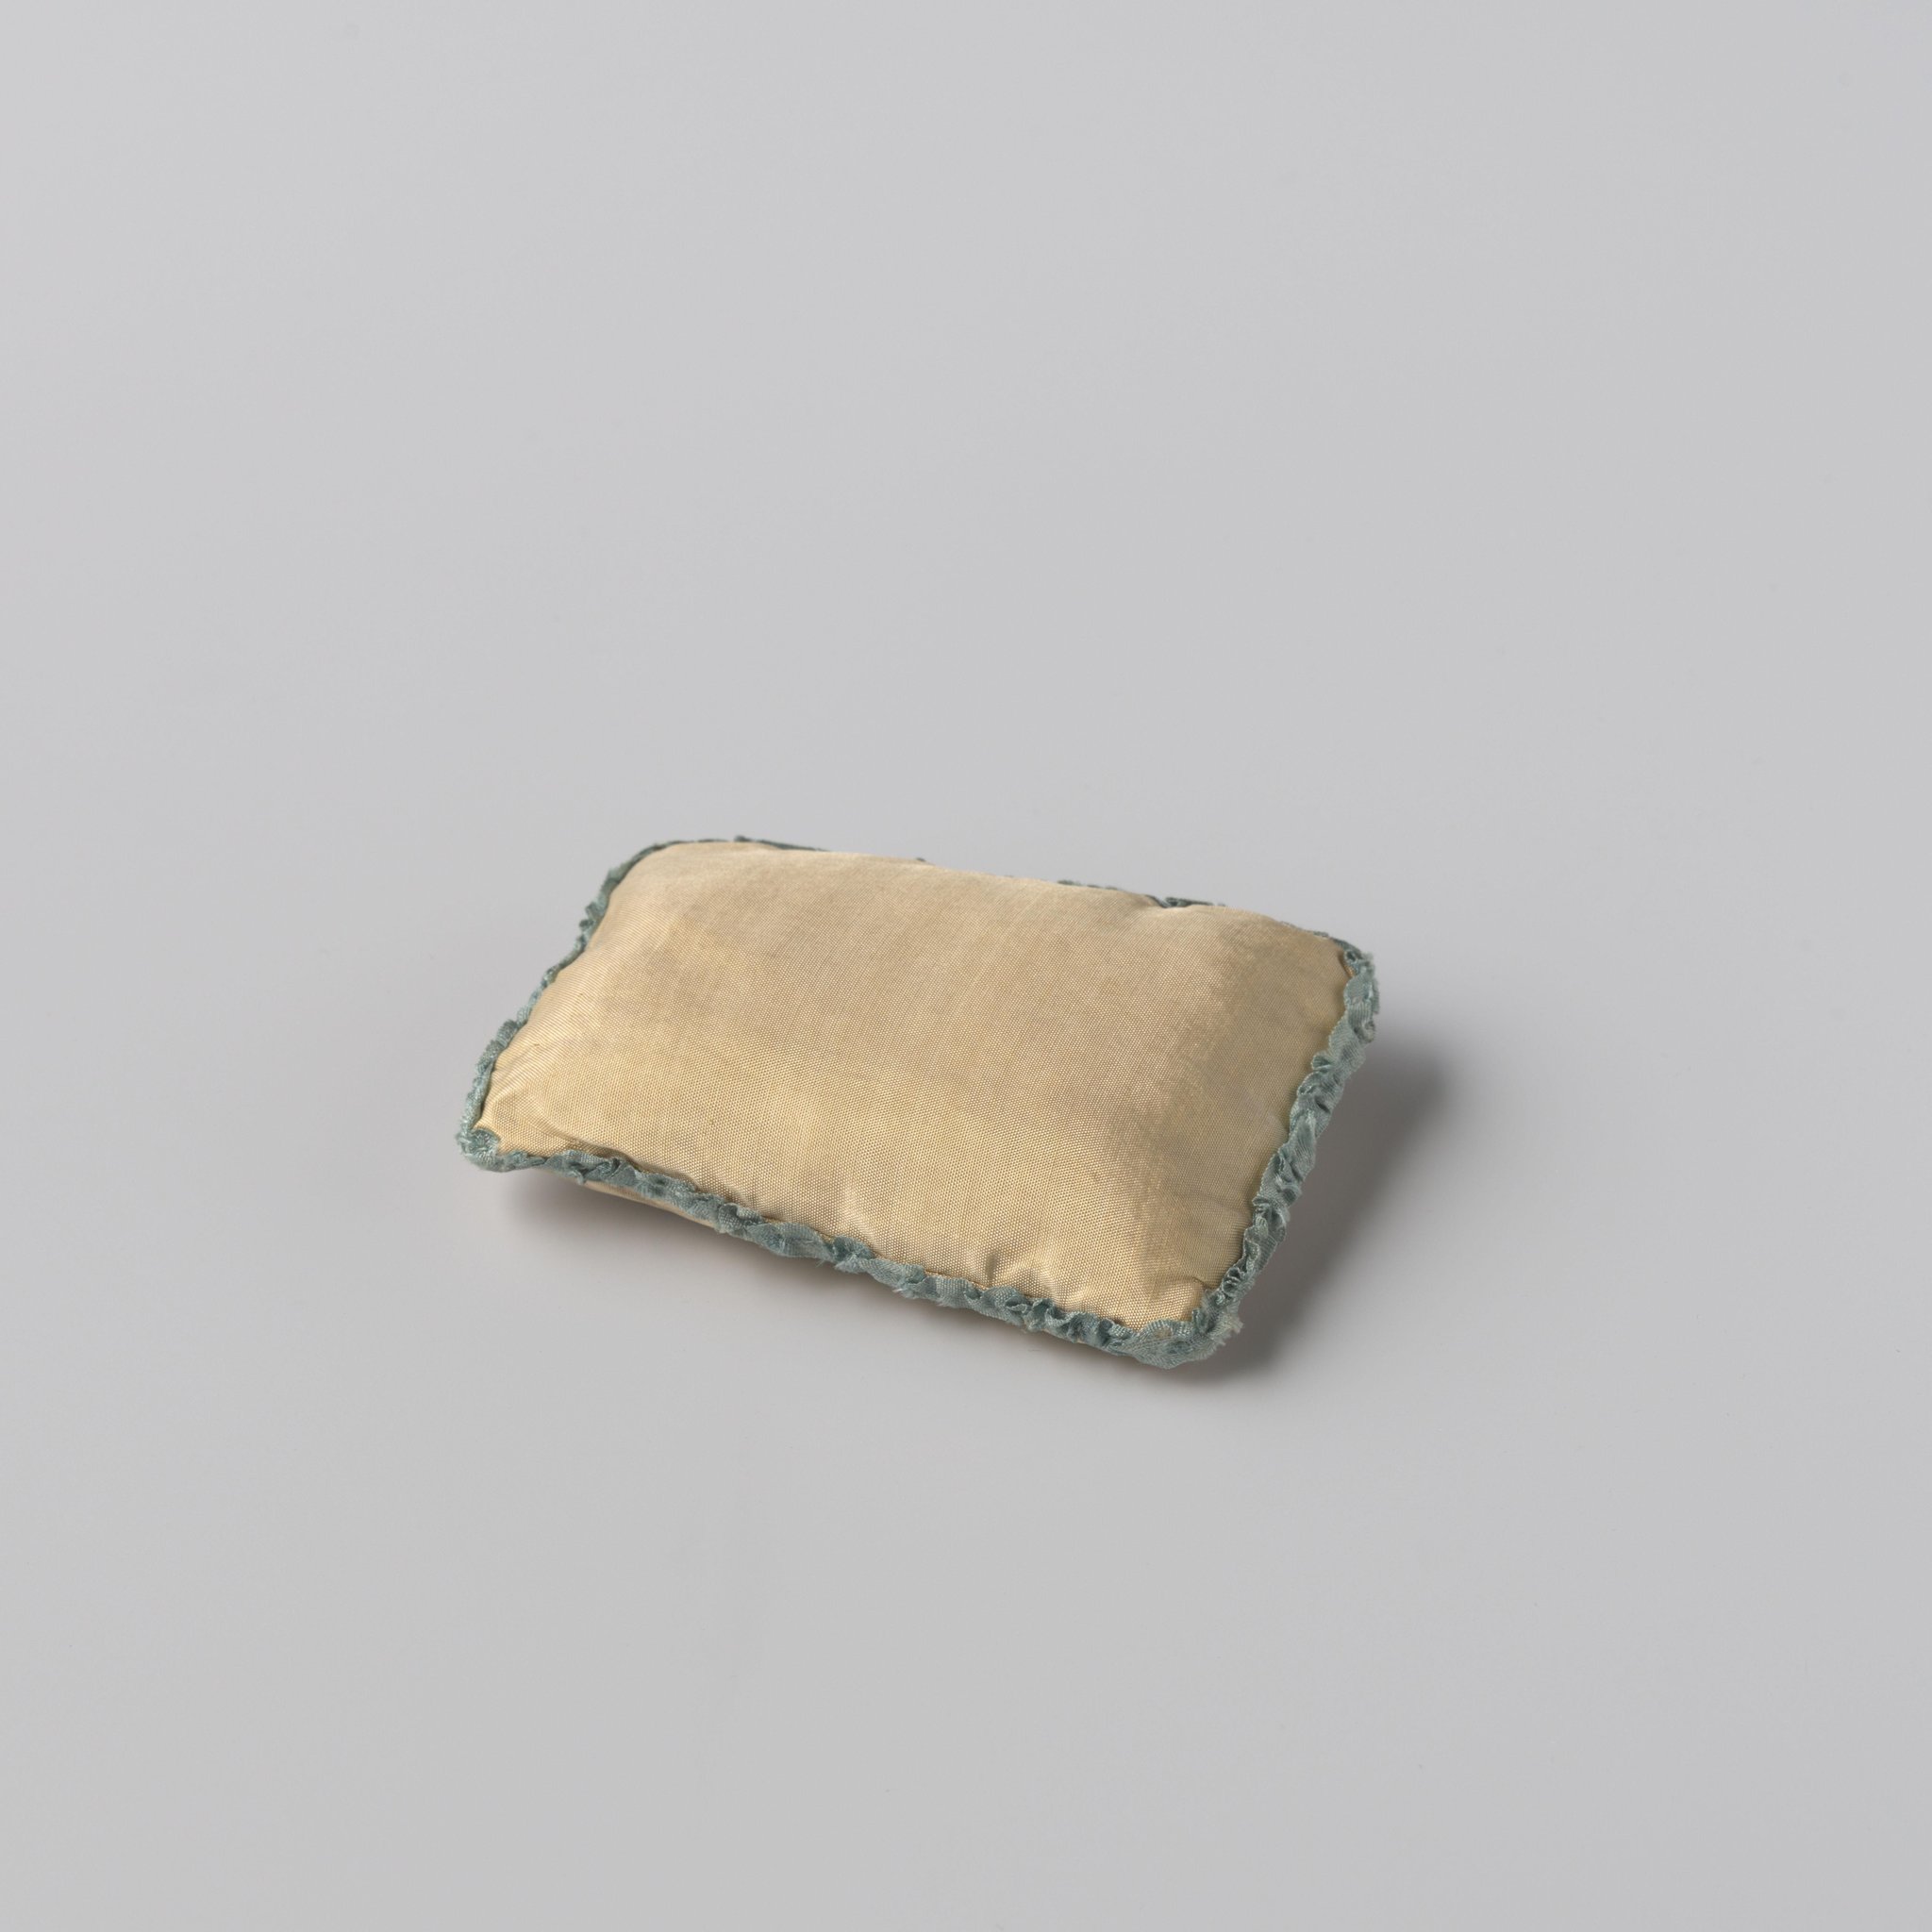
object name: miniature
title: Rechthoekig kussen vervaardigd van licht gele zijde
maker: Anonymous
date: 1690-1710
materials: down, silk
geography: amsterdam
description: Rechthoekige kussen vervaardigd van licht gele zijde, rondom afgezet met een ingerimpeld lintje van licht blauwe zijde. De kussens zijn gevuld met dons oorspronkelijk zonder tussenvoering.